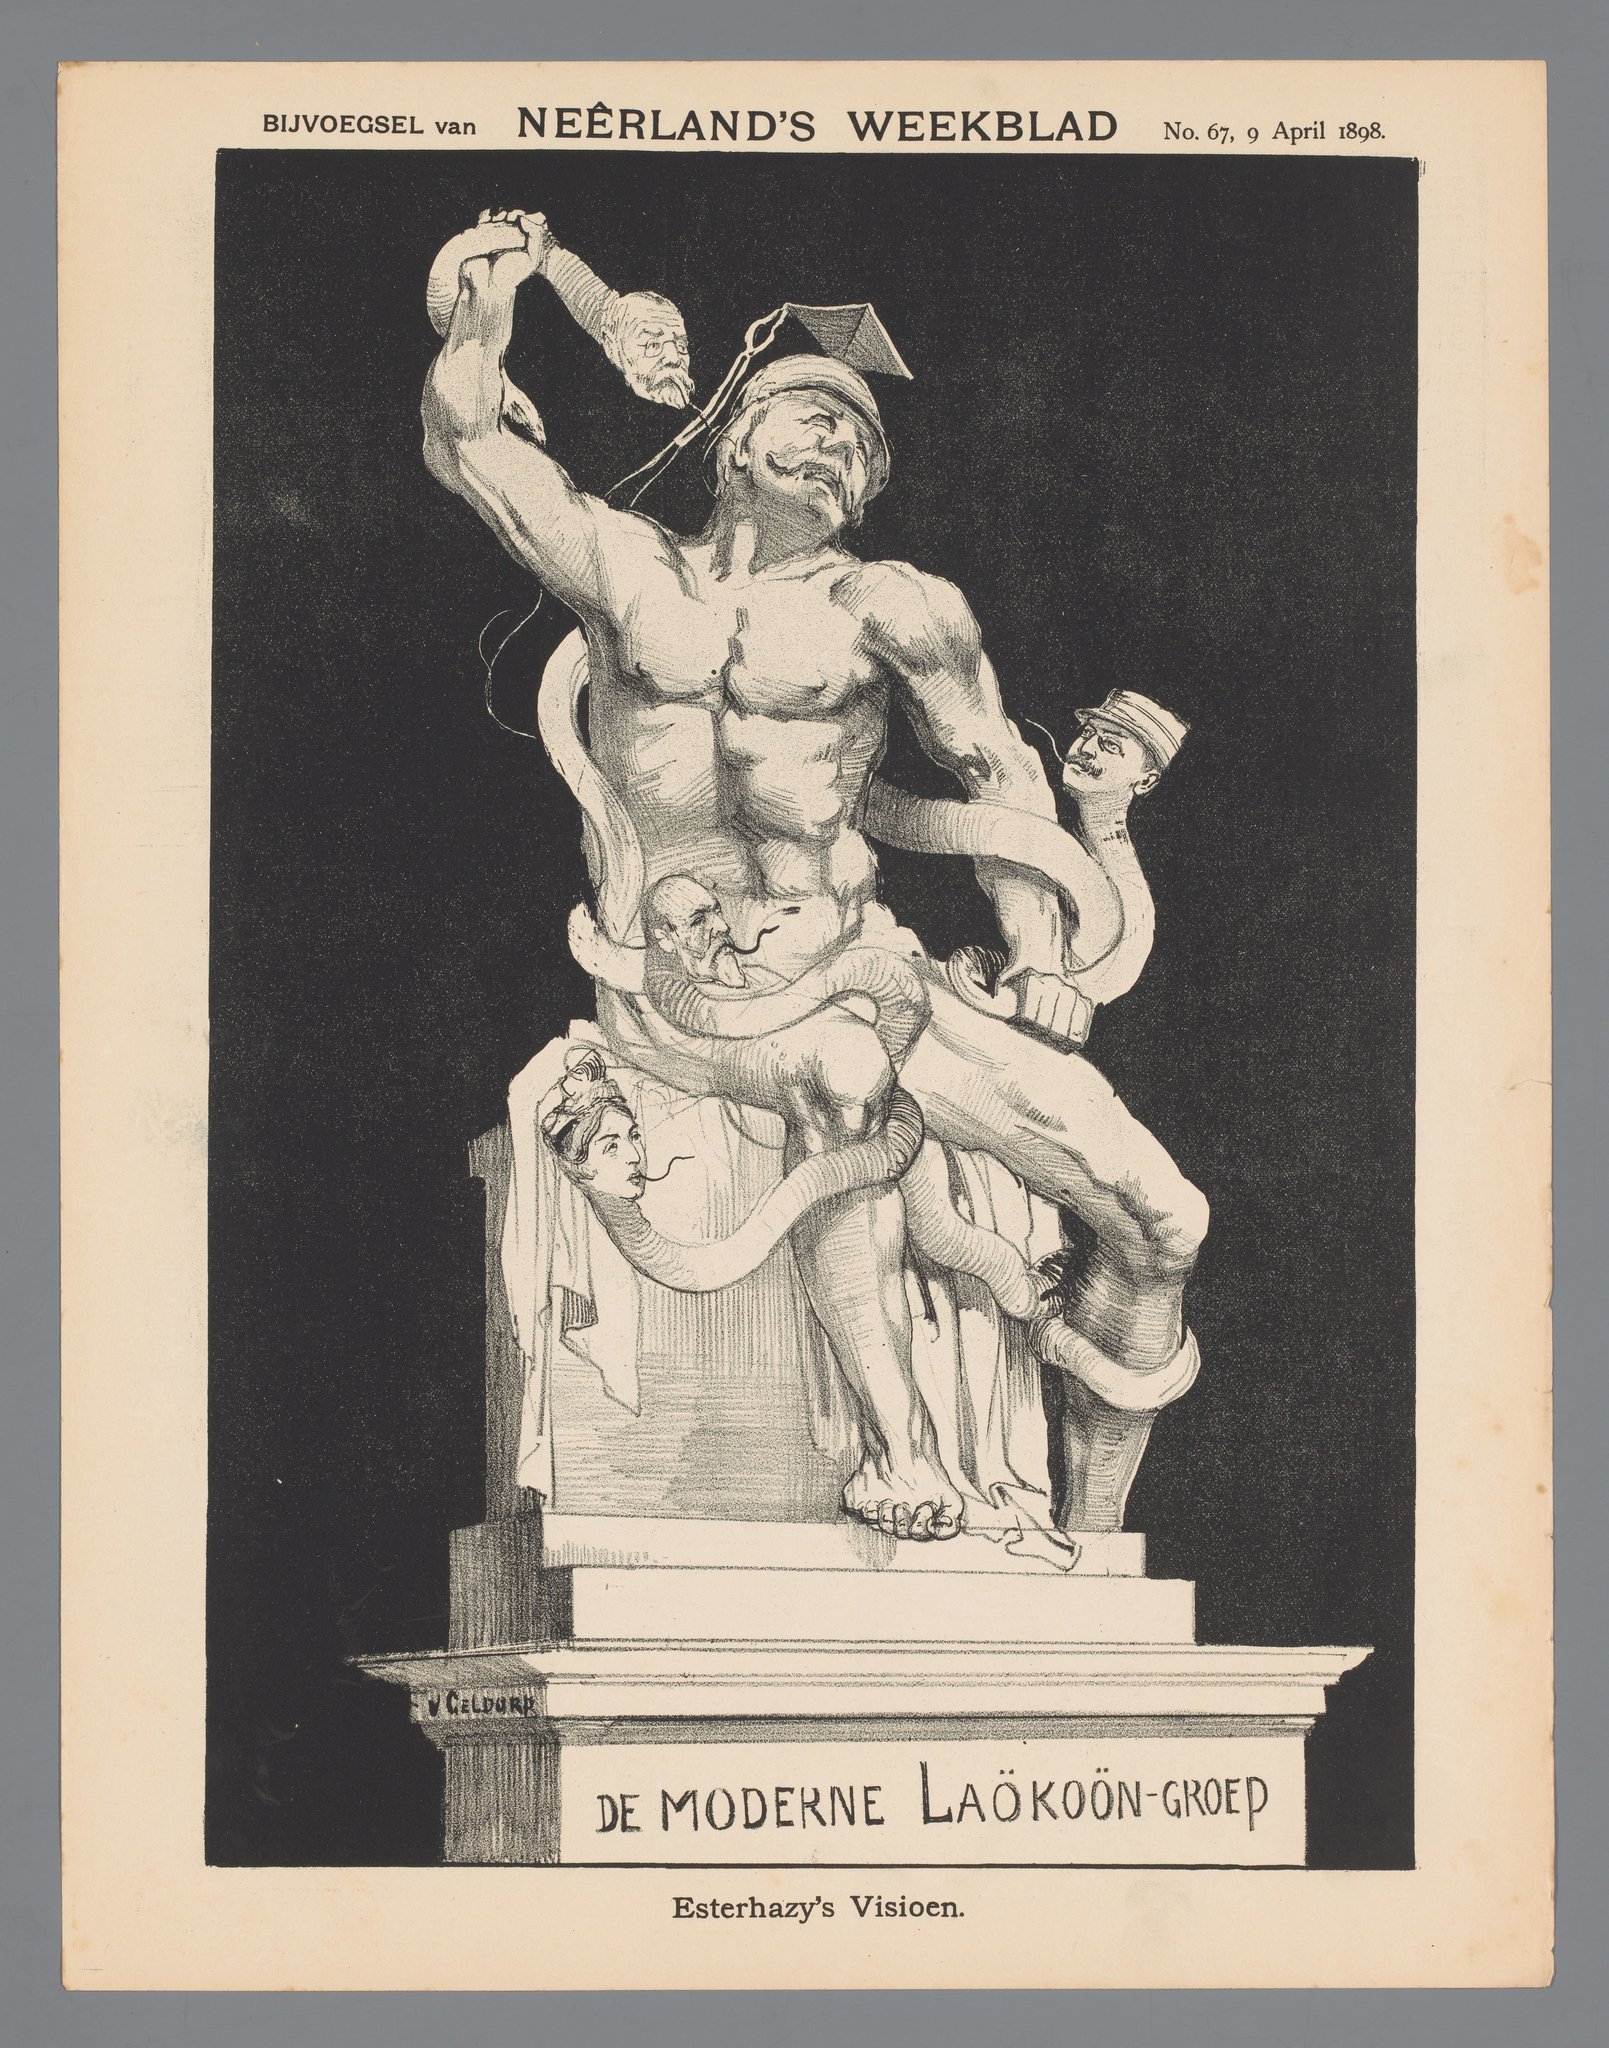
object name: cartoon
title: Esterhazy's Visioen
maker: petrus van geldorp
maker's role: draughtsman, print maker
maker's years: 1872-1939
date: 1898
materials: paper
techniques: lithograph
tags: laocoon and his twin sons are strangled by two serpents during the preparations for a sacrifice (+ variant), piece of sculpture, reproduction of a piece of sculpture, political caricatures and satires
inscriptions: date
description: Prent uit het bijvoegsel van: Neêrland’s Weekblad, nr. 67, 9 april 1898.